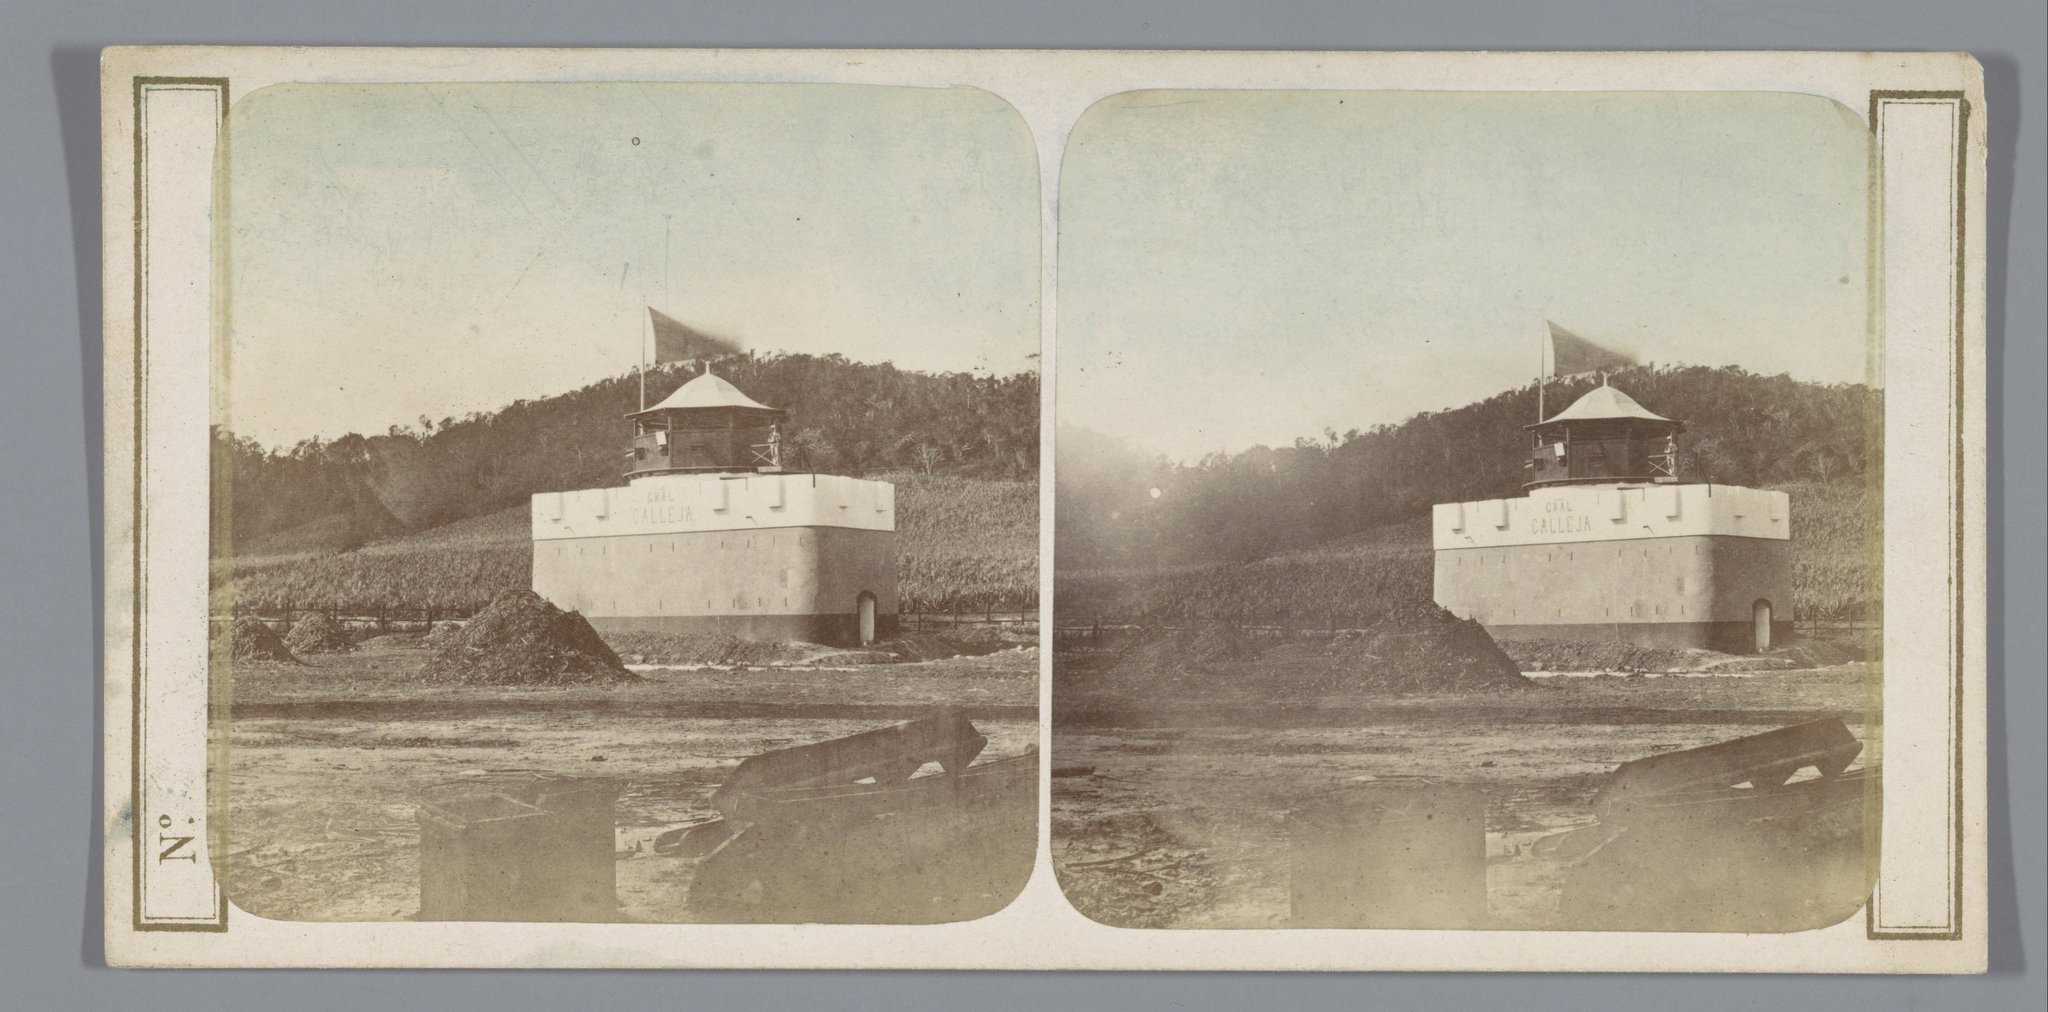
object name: stereograph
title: Gezicht op fort Cral Calleja te Spanje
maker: Anonymous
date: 1860-1875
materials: cardboard, photographic support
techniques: albumen print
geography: spain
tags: fortress, spain